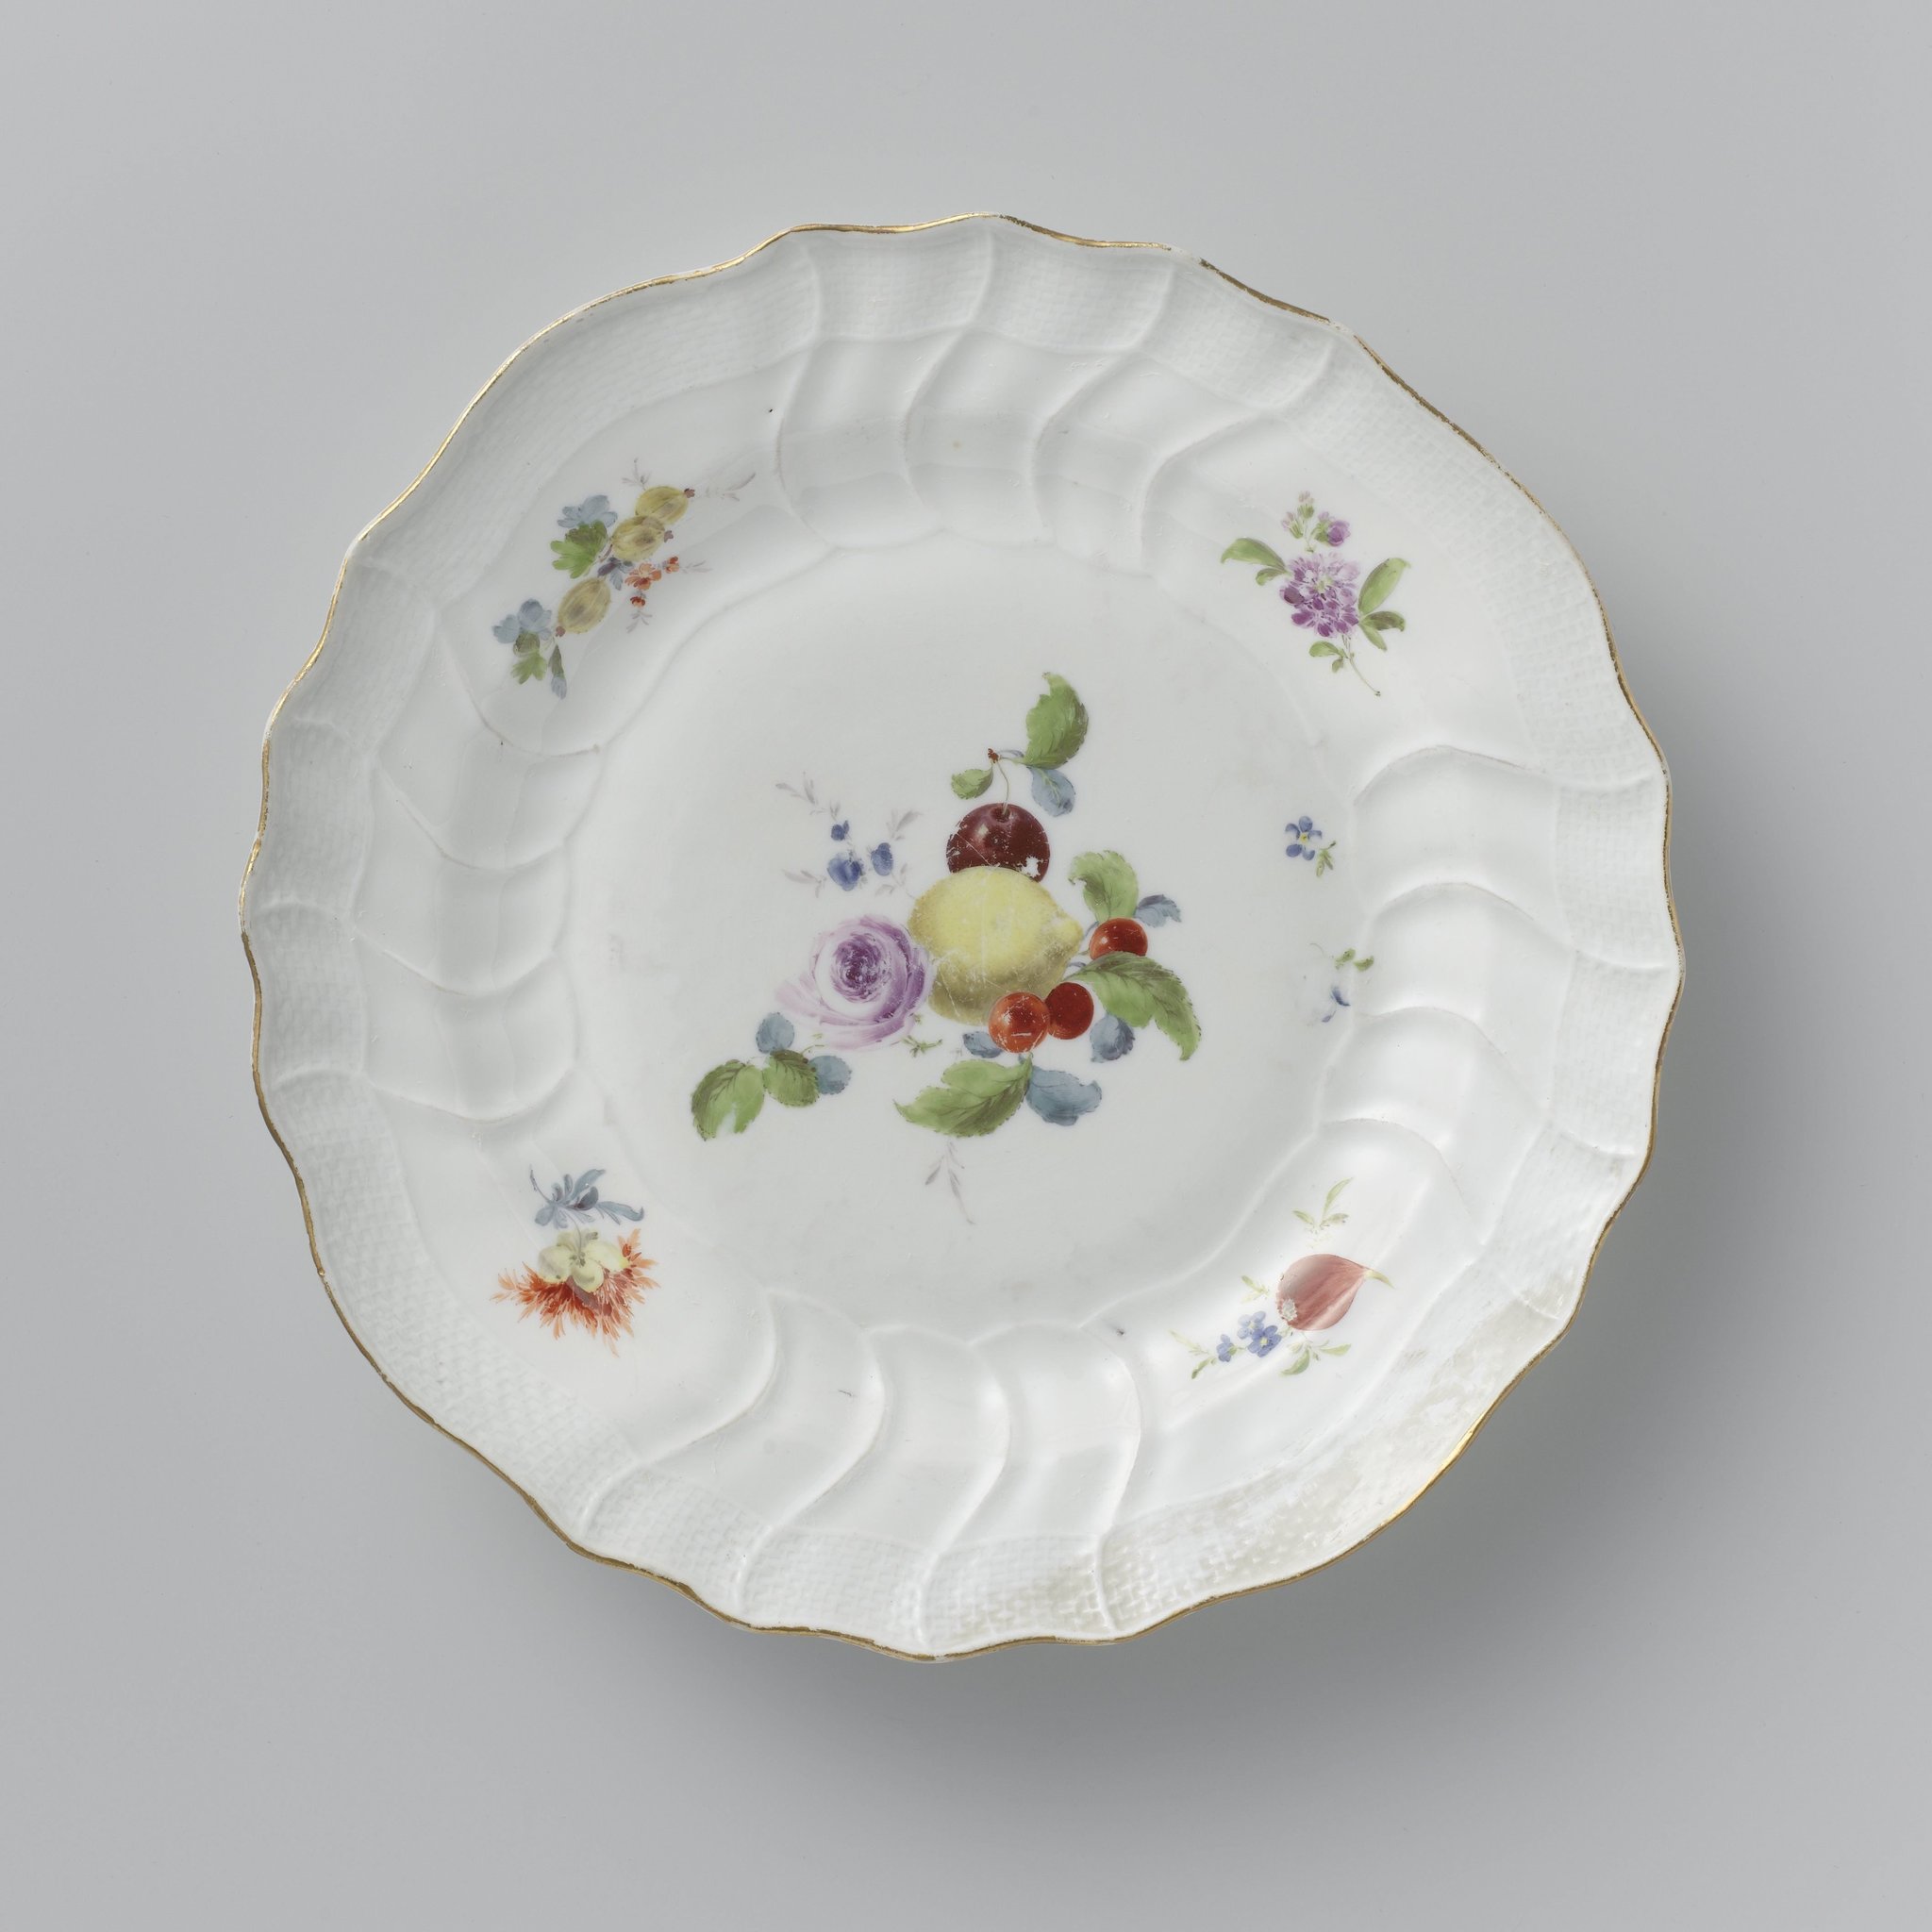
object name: eating drinking utensil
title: Bord, veelkleurig beschilderd met Deutsche Blumen, insekten en vruchten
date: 1750-1760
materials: porcelain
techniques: painted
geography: meissen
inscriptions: factory mark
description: Rond bord van beschilderd porselein. Het bord is beschilderd met Deutsche Blumen, insekten en vruchten. De rand is in reliëf versierd met het Neuozier-patroon. Het bord is gemerkt en hoort bij een servies (BK-17474-1 t/m BK-17474-253).